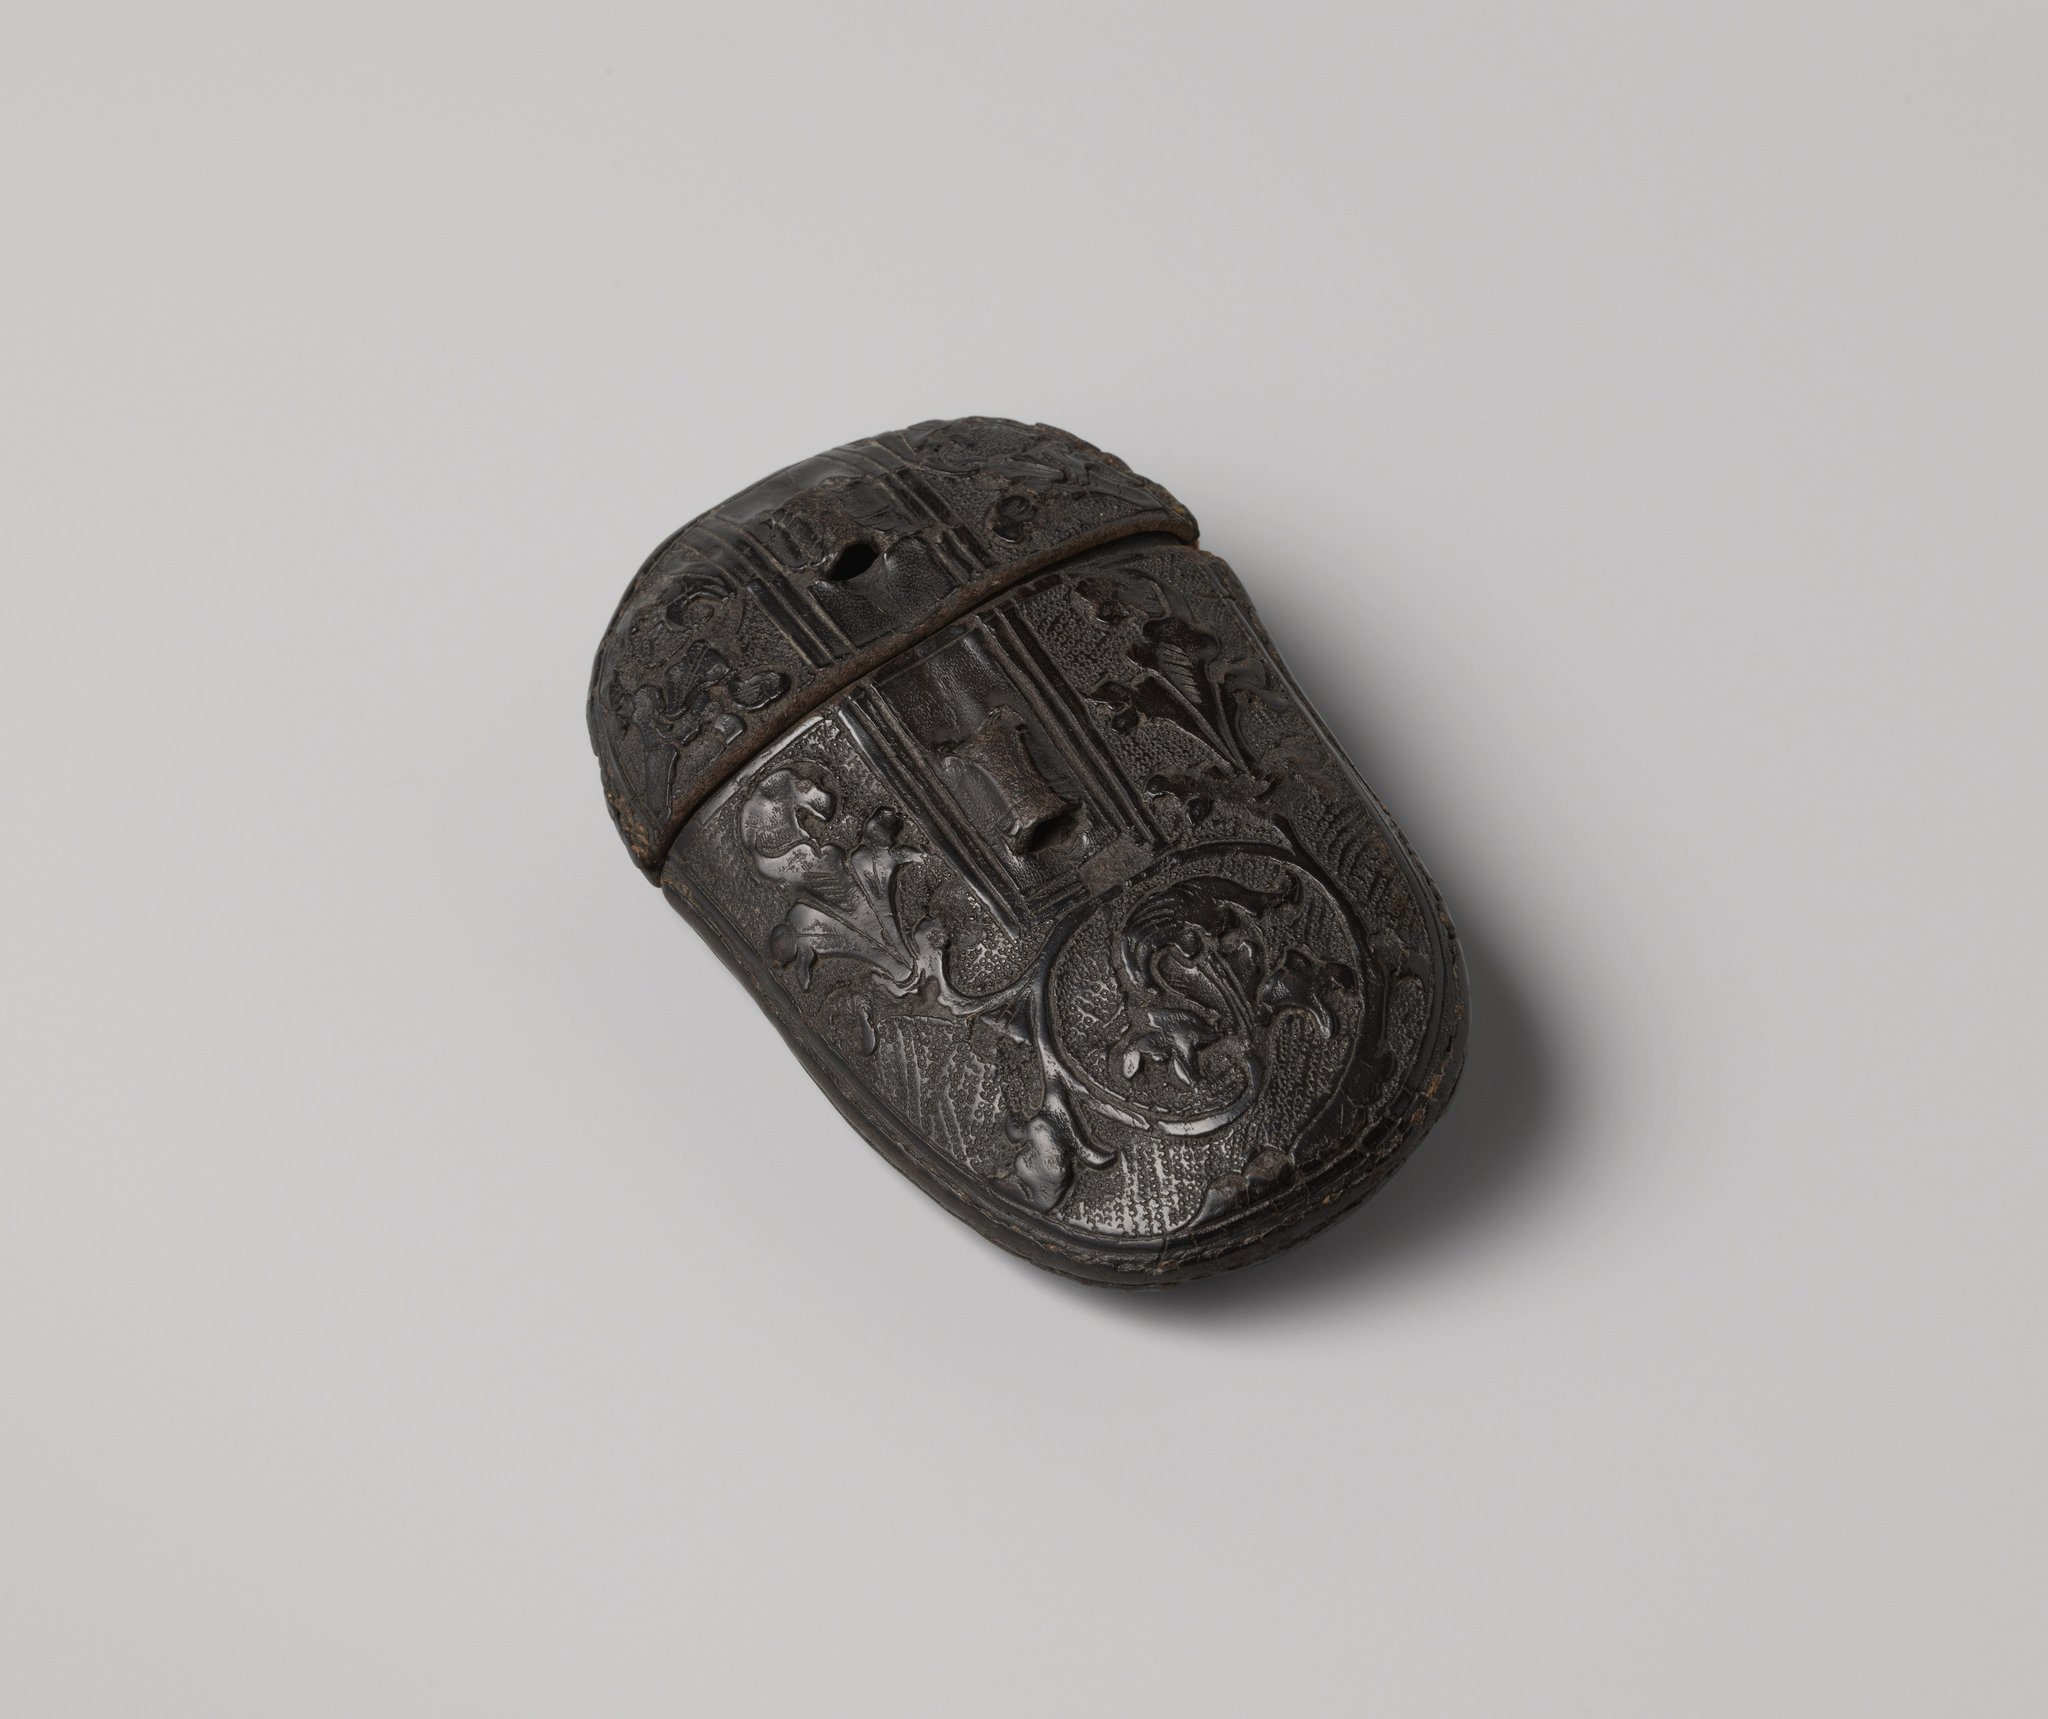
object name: case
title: Foedraal van geperst leer met bloemversieringen.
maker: Anonymous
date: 1500-1600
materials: leather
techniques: pressing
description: Foedraal met deksel, van geperst leer met bloemversieringen. Plat, ovaalvormig met passanten.